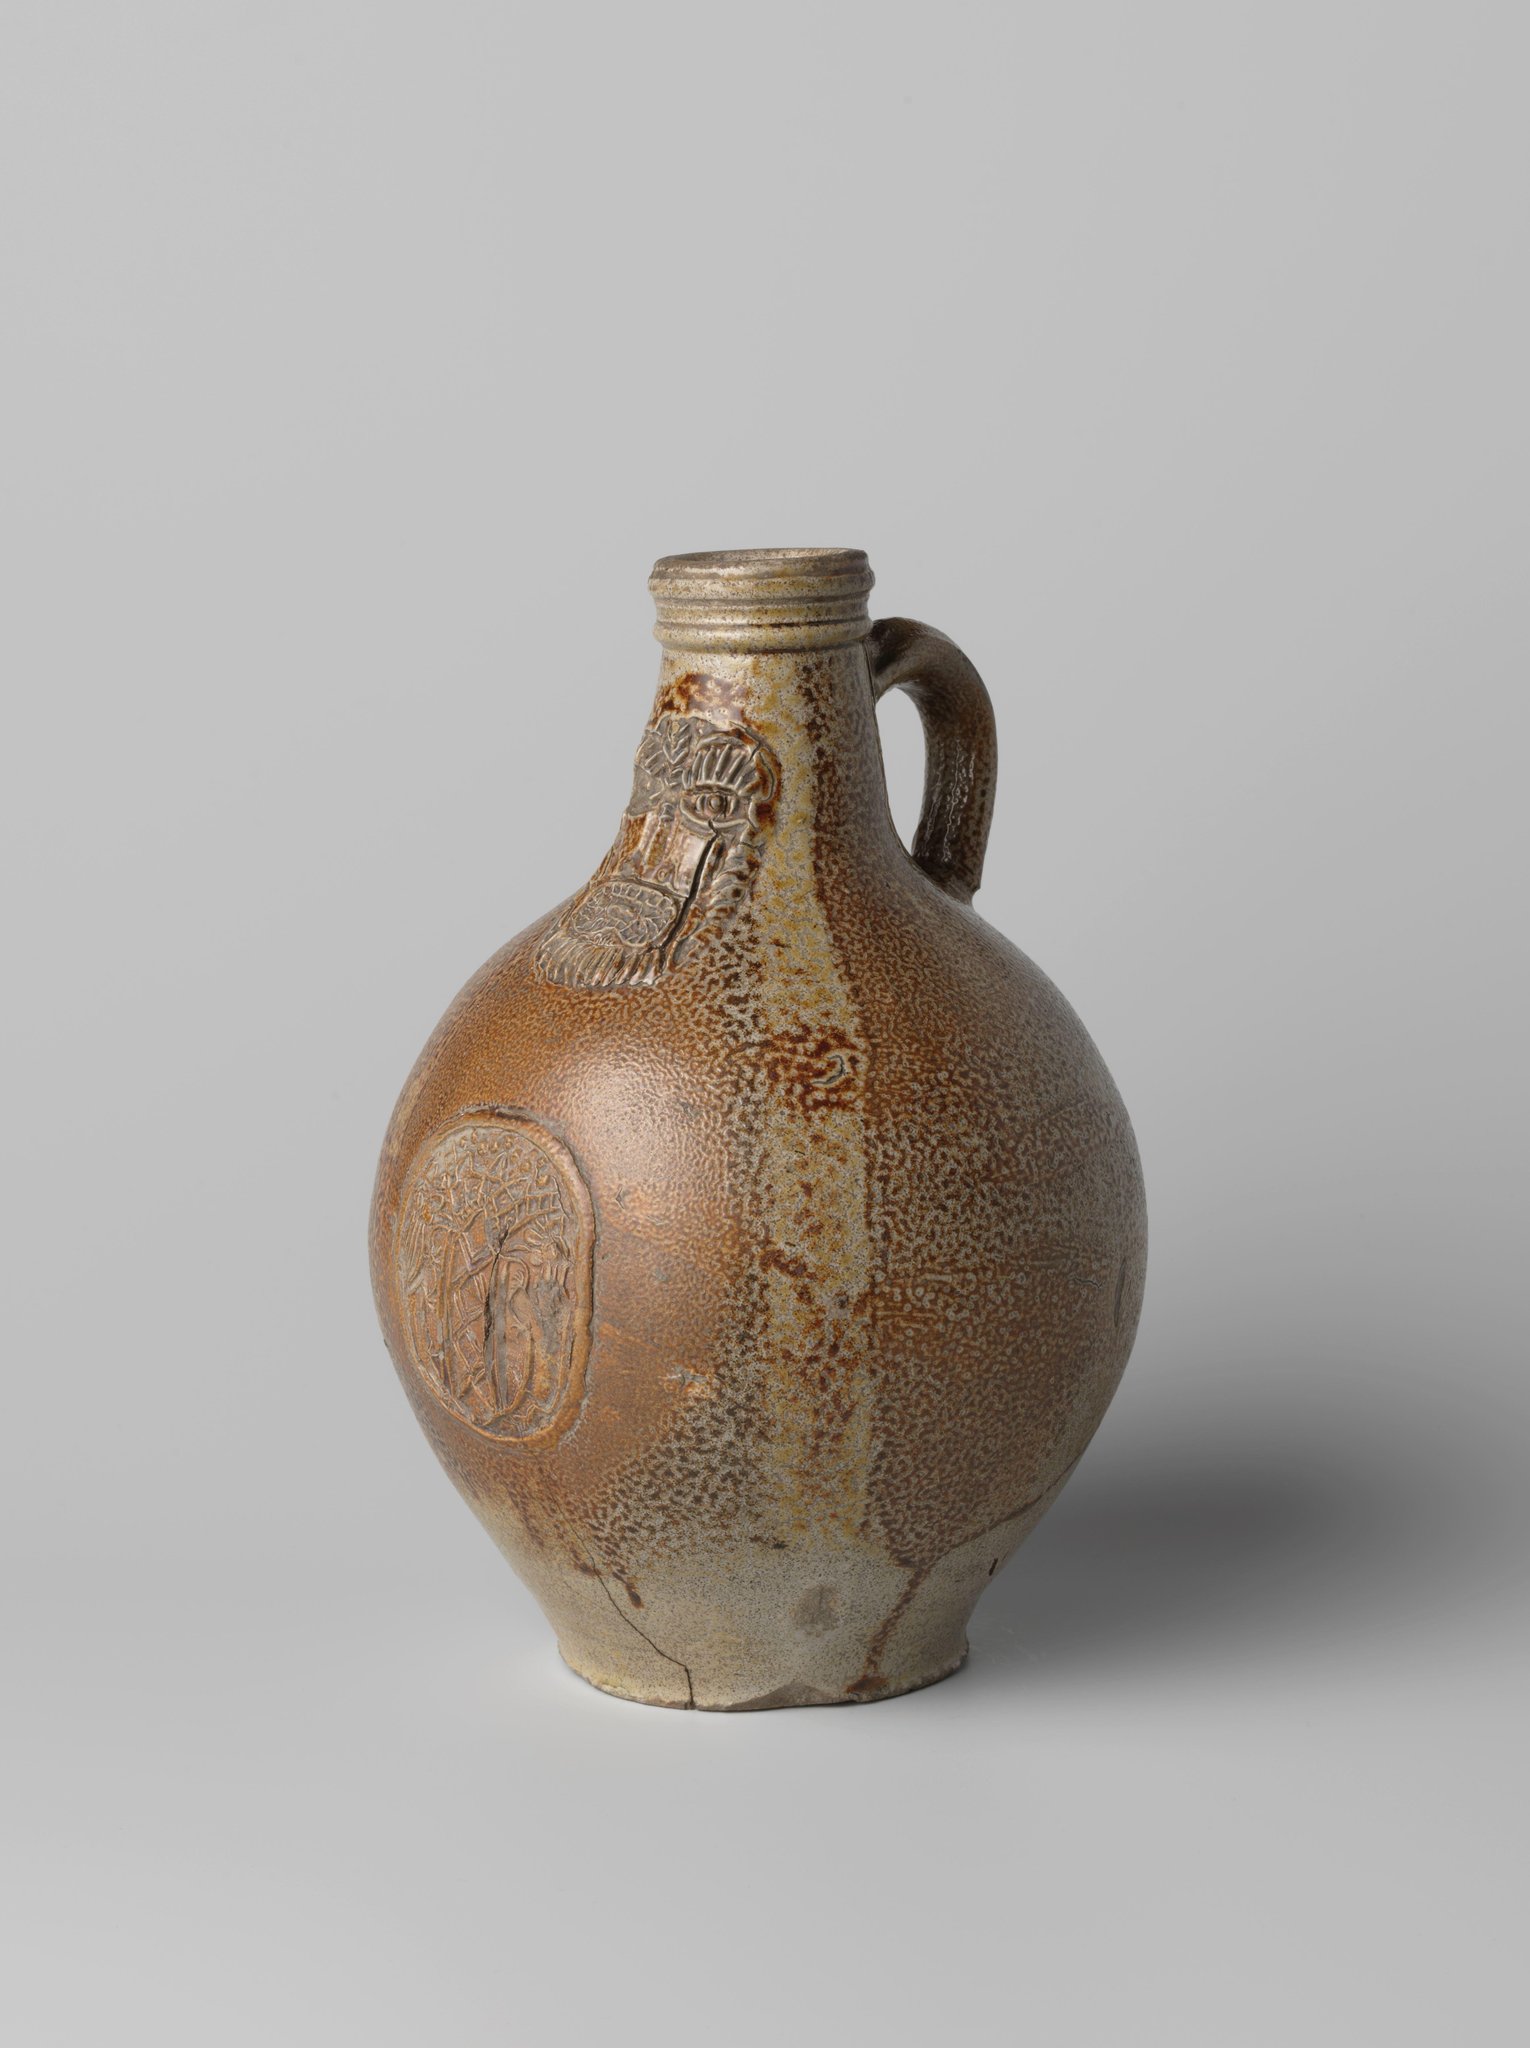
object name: jug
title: Jug (Bartmann jug) with the coat of arms of Amsterdam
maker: Anonymous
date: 1625-1749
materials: engobe, glaze, stoneware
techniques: firing, forming, relief, turning, vitrification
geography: frechen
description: Kruik (baardmankruik) van steengoed op standvlak met een bolvormig lichaam en smalle nek. Het C-vormige oor is bevestigd aan de nek en de schouder. Profielen op de nek en de voet. Bedekt met een bruine engobe. De buik met in reliëf een gedrukt en opgelegd medaillon met daarin het wapen van Amsterdam. Op de nek, doorlopend op de schouder, een baardman. Frechen.